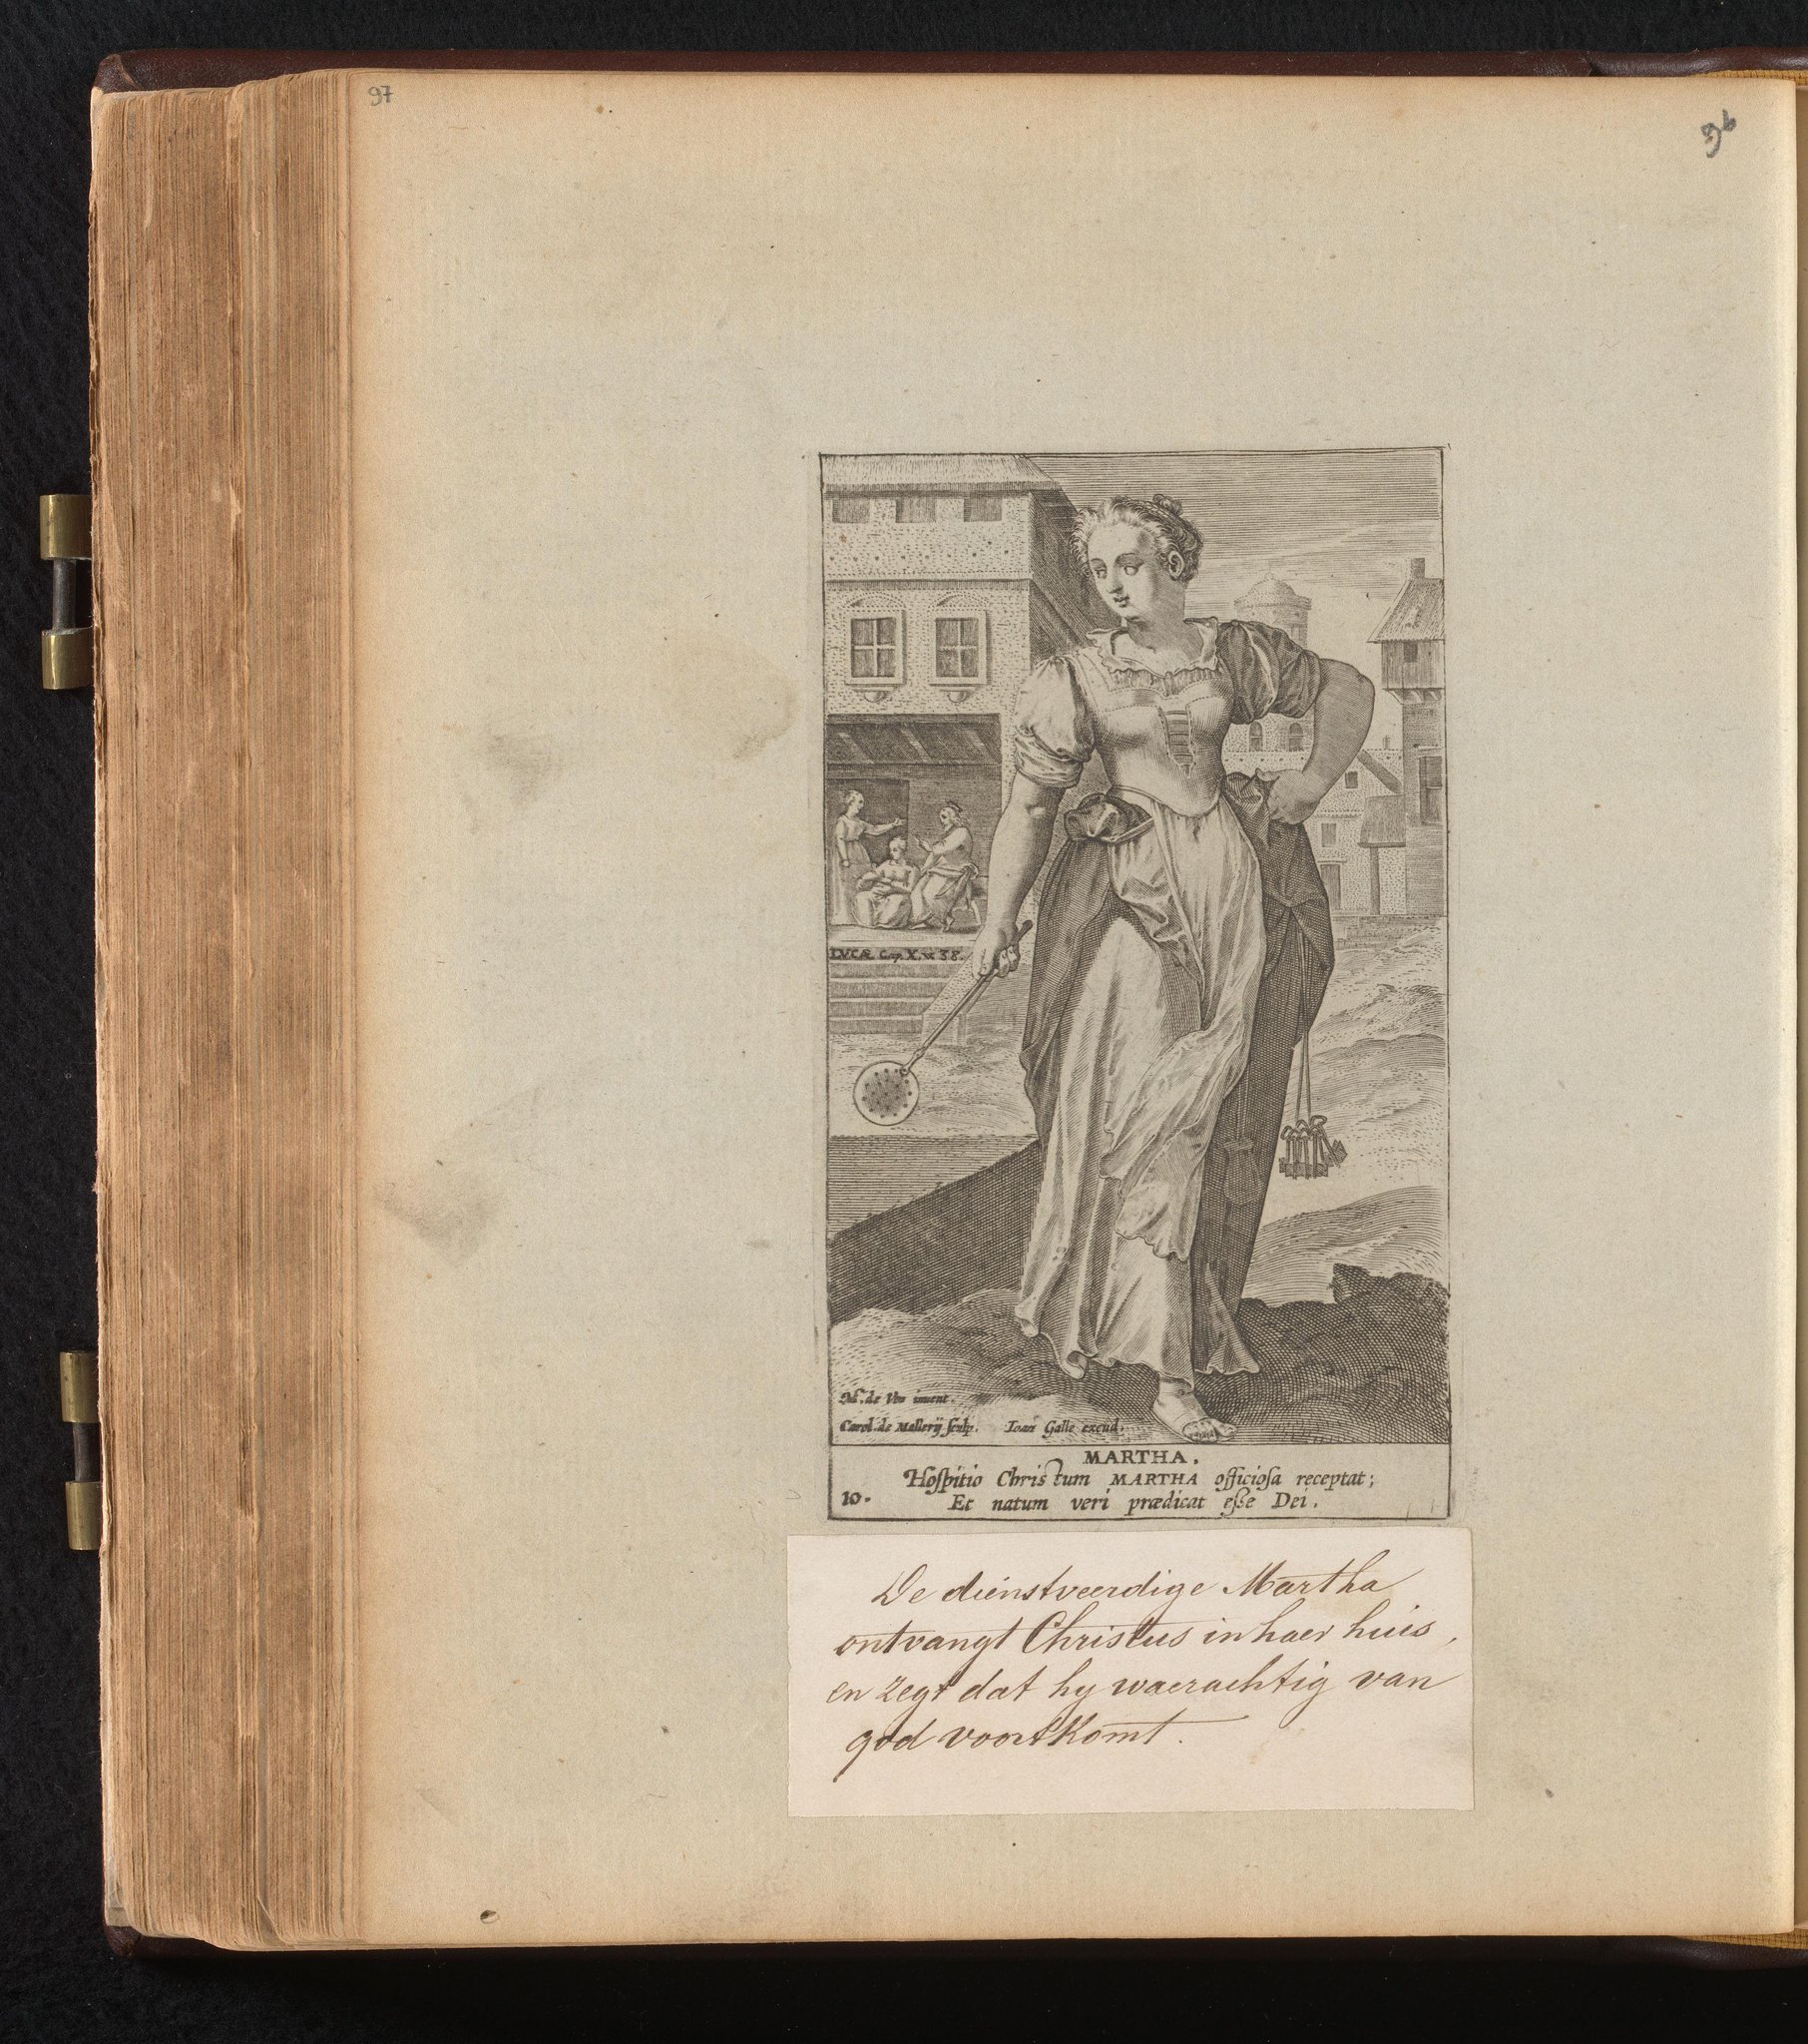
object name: print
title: Martha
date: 1599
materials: paper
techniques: engraving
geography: antwerp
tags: the patroness of housewives, martha of bethany; possible attributes: aspergillum, broom, bunch of keys, dragon, ladle, martha complains to christ about mary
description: Prent maakt deel uit van een prentbijbel.